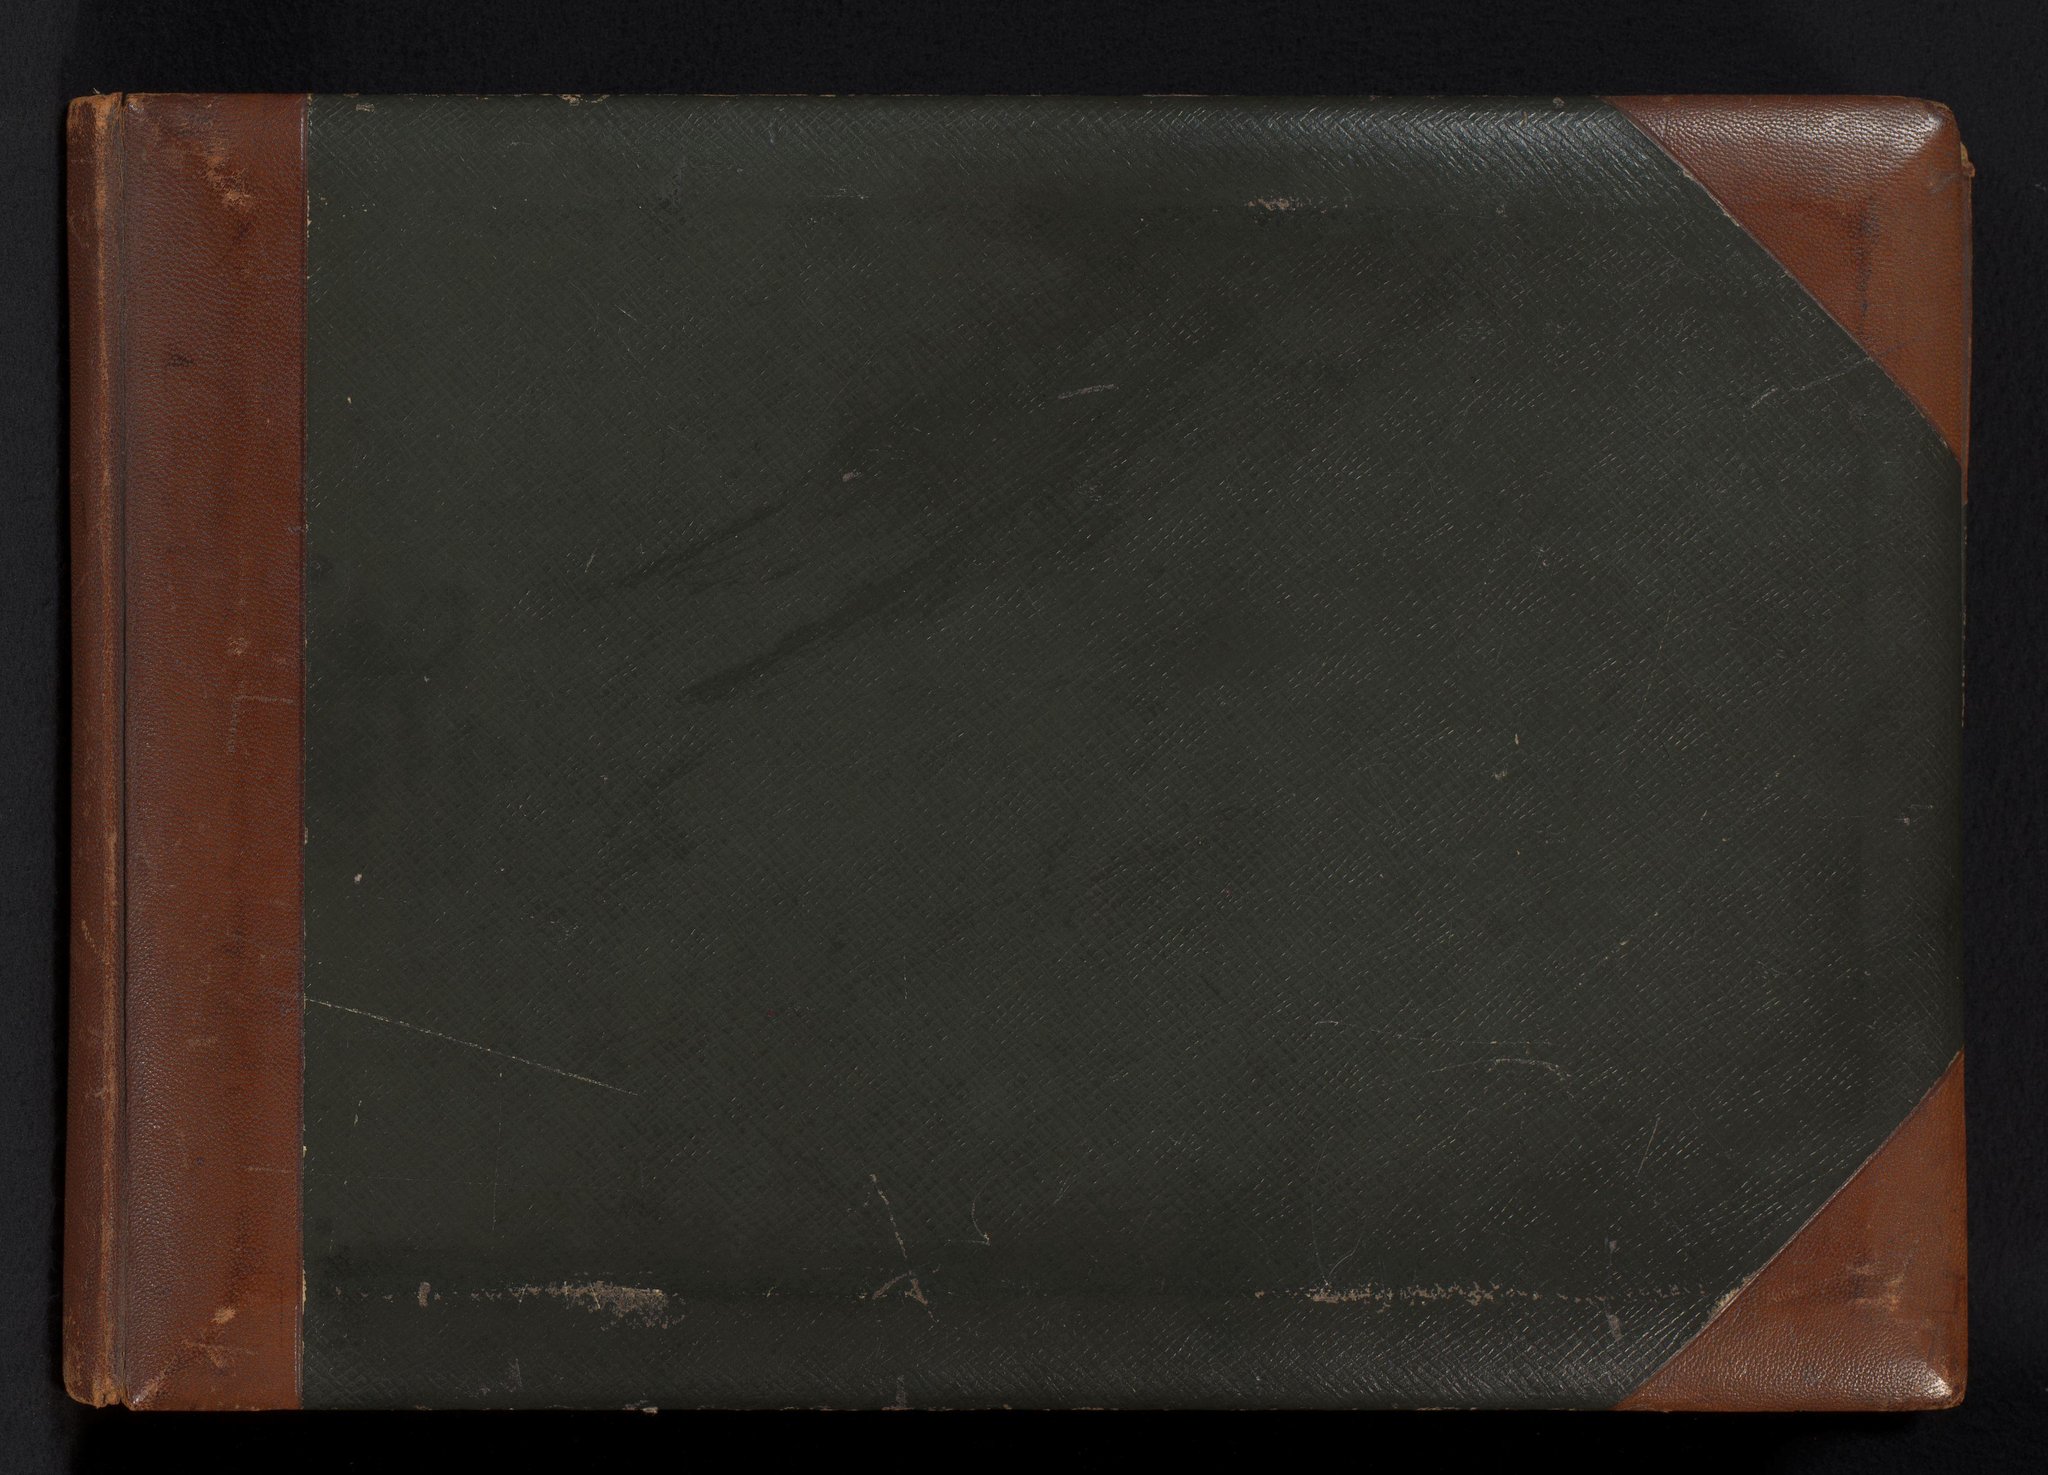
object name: scrapbook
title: Reisalbum met opnames van bezienswaardigheden in Zweden, Noorwegen, Denemarken, Beieren, Milaan en Parijs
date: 1860-1900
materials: cardboard, leather, paper, photographic support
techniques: albumen print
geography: netherlands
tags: travelling; tourism, prospect of city, town panorama, silhouette of city, denmark, paris, norway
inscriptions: name: ‘S.P.A. Koumans Boekbinder en Kartonverwerker Delft’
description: Fotoalbum in donkergroene band, de rugband en hoekpunten uitgevoerd in leer. Het album bevat 22 bladen met 56 afdrukken. De afdrukken worden beschermd door schutbladen met een geometrisch bloemmotief. De opnames zijn gemaakt in Zweden, Noorwegen, Denemarken, Beieren, Milaan en Parijs. Het album betreft voornamelijk foto's van landschappen, watervallen, monumenten en kerken. Gelet op de sticker van de Delftse firma S.P.A. Koumans op het voorste schutblad, is de albumsamensteller mogelijk een Nederlander geweest.